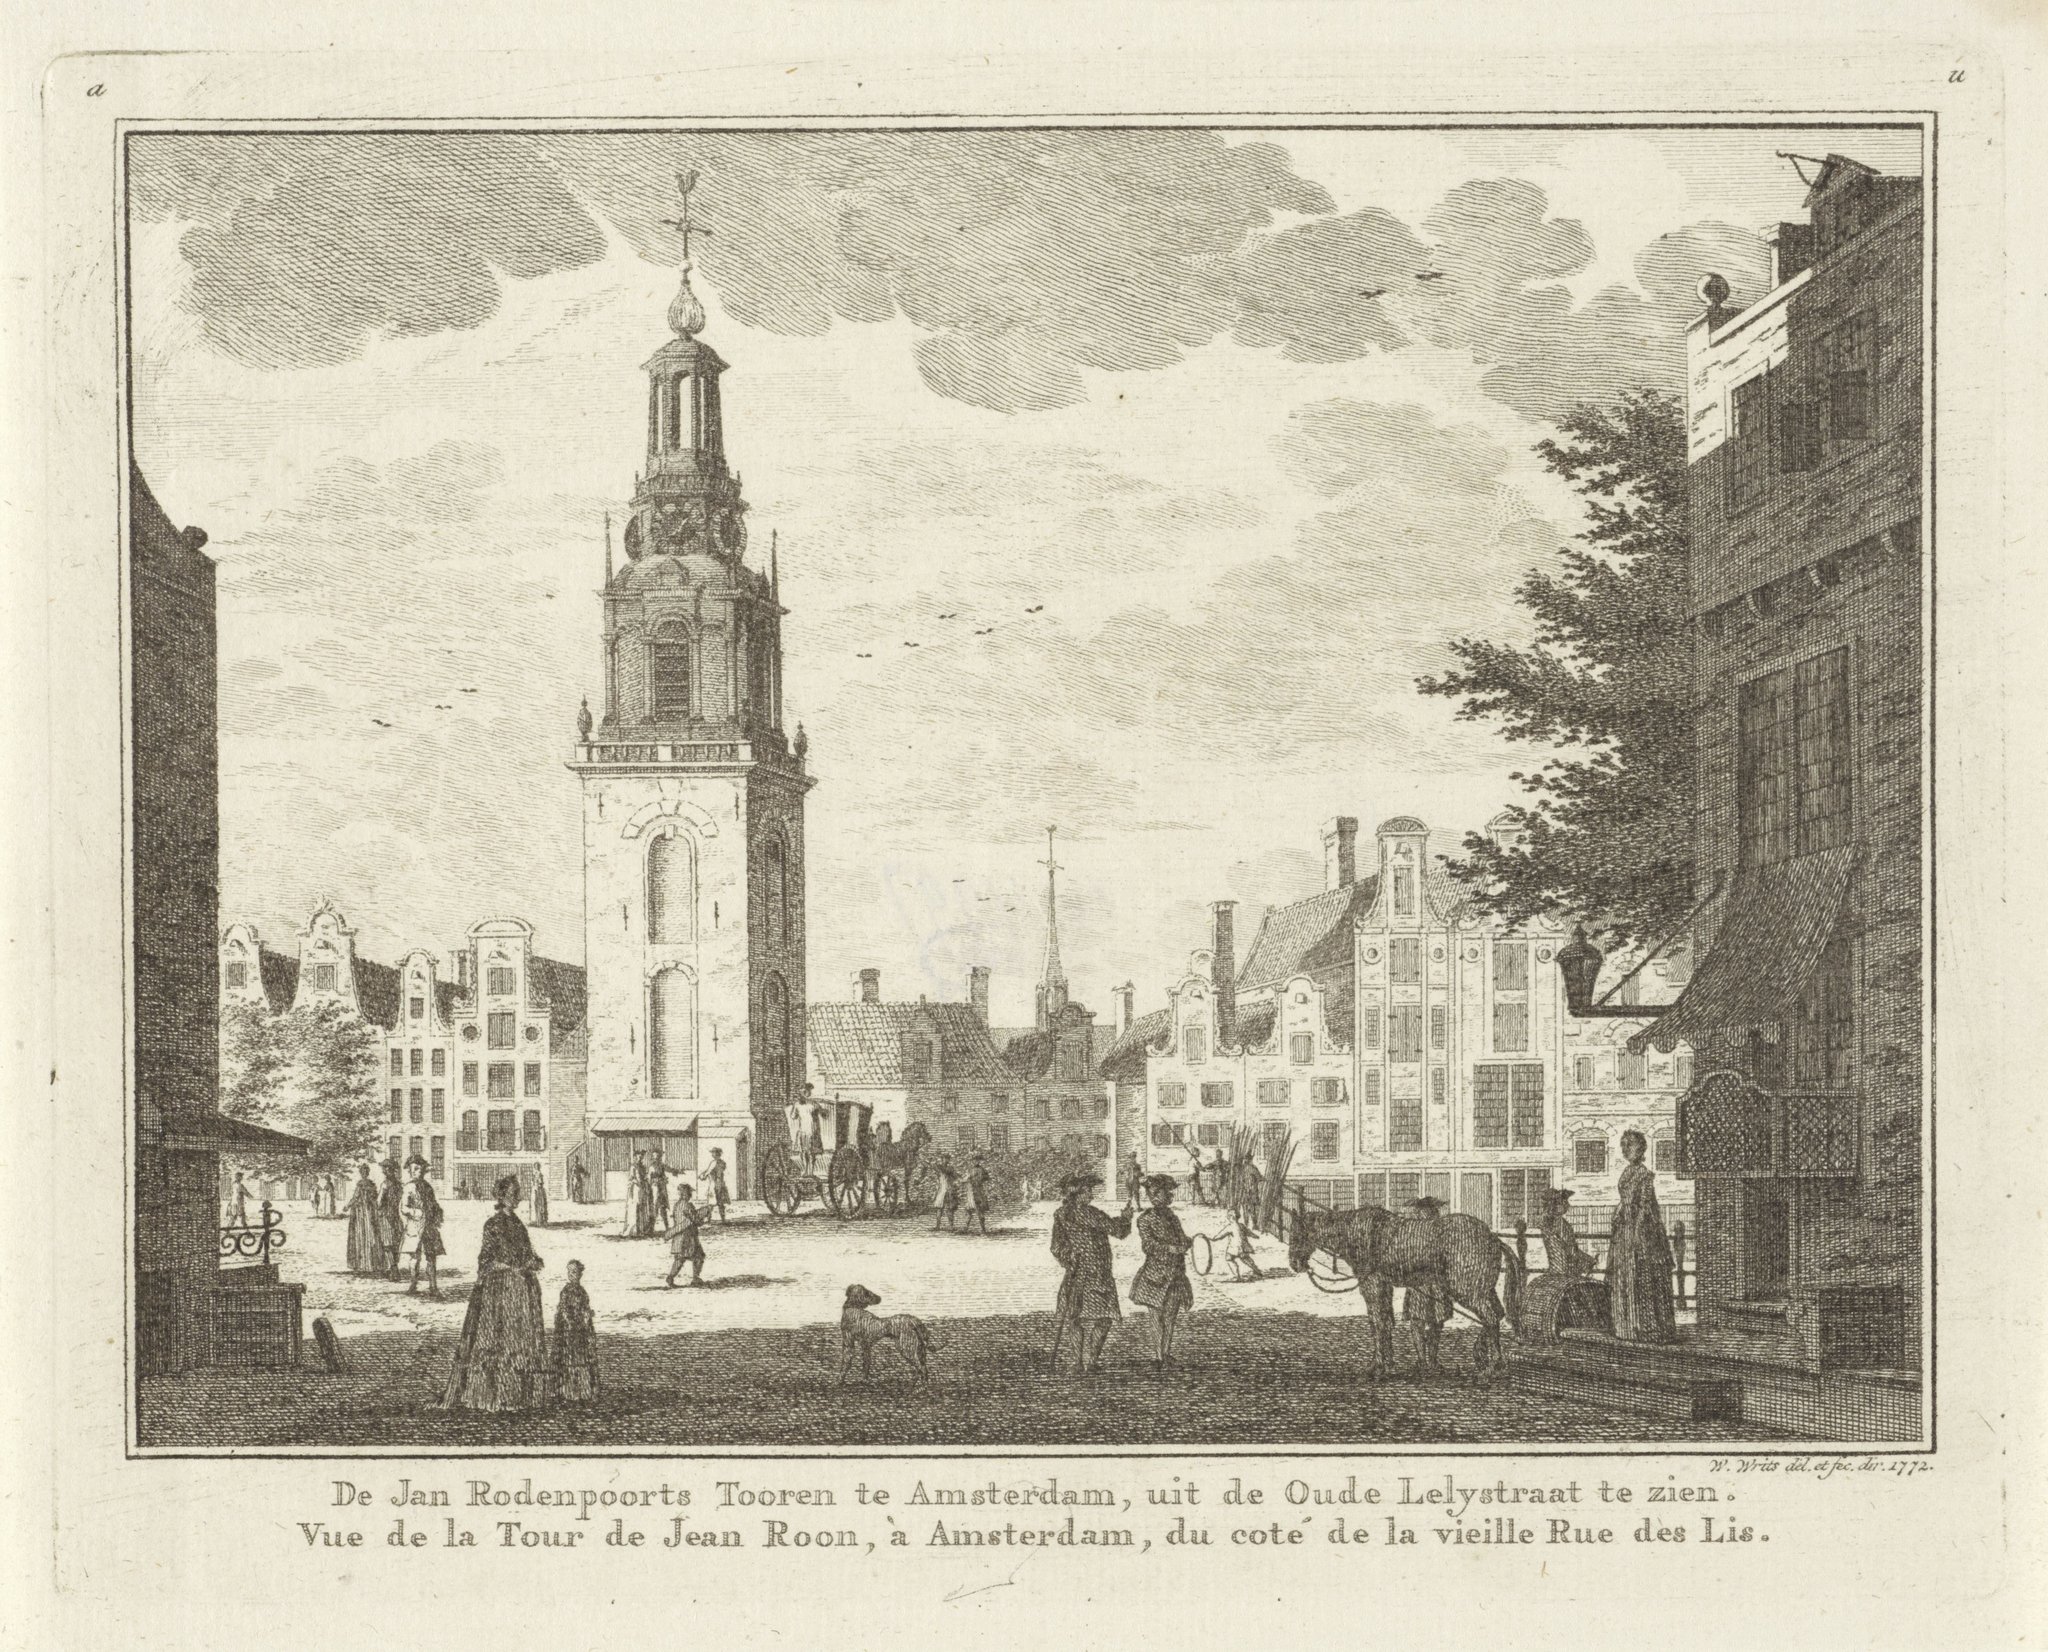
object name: print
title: Gezicht op de Jan Roodenpoortstoren te Amsterdam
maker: willem writs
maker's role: draughtsman, print maker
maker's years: 1731-1786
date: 1772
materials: paper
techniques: etching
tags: jan roodenpoortstoren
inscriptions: collector's mark: Lugt 2228